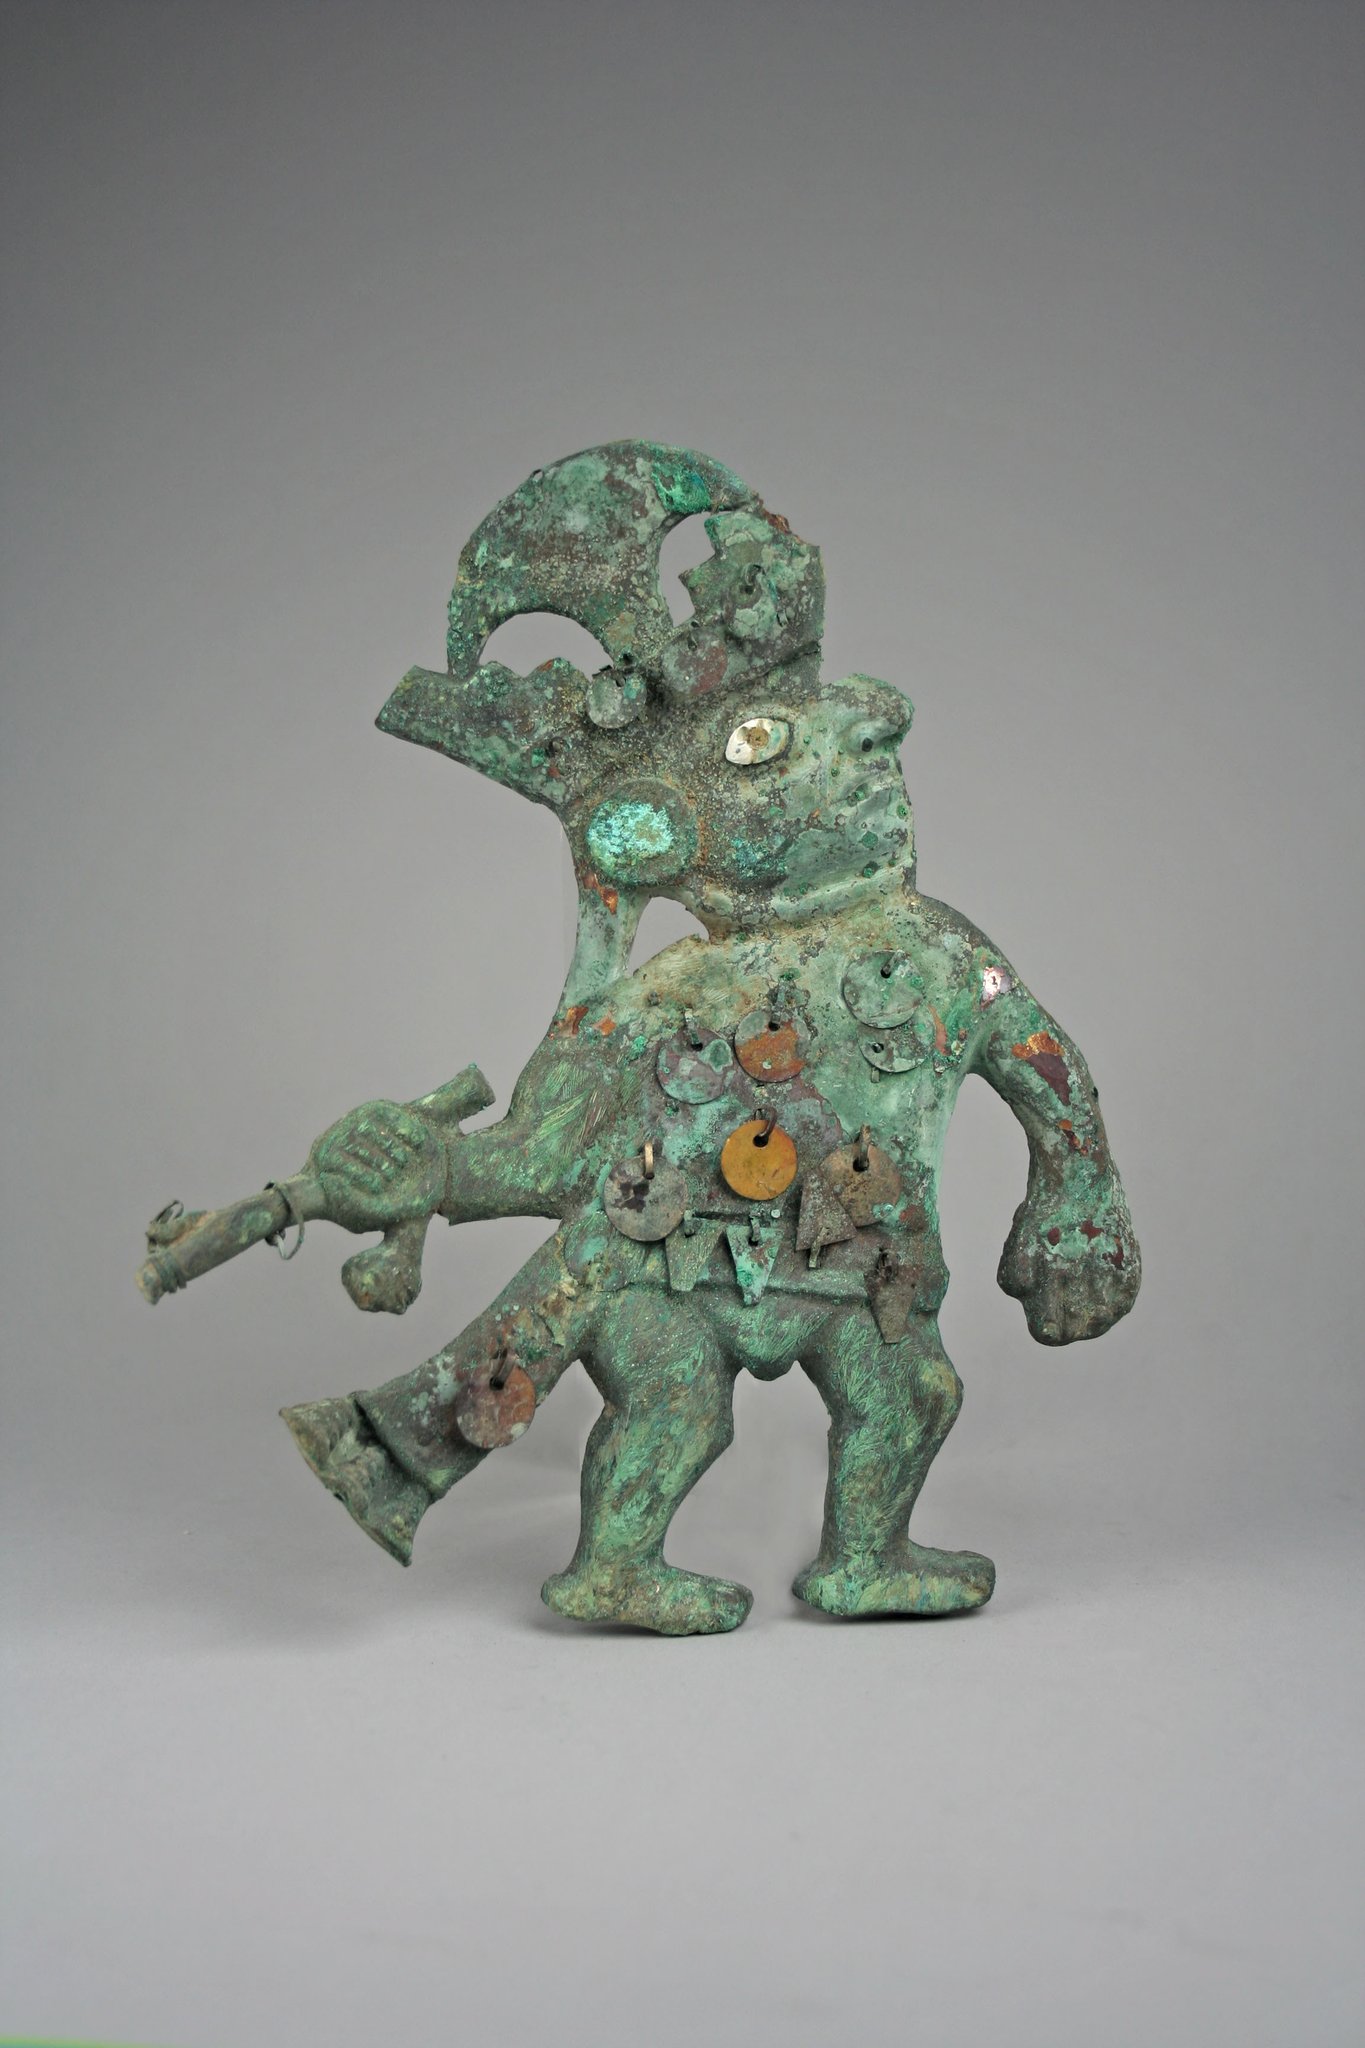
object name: ornament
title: Profile Warrior Ornament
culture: moche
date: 501-700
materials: gilt copper, shell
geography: peru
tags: warriors